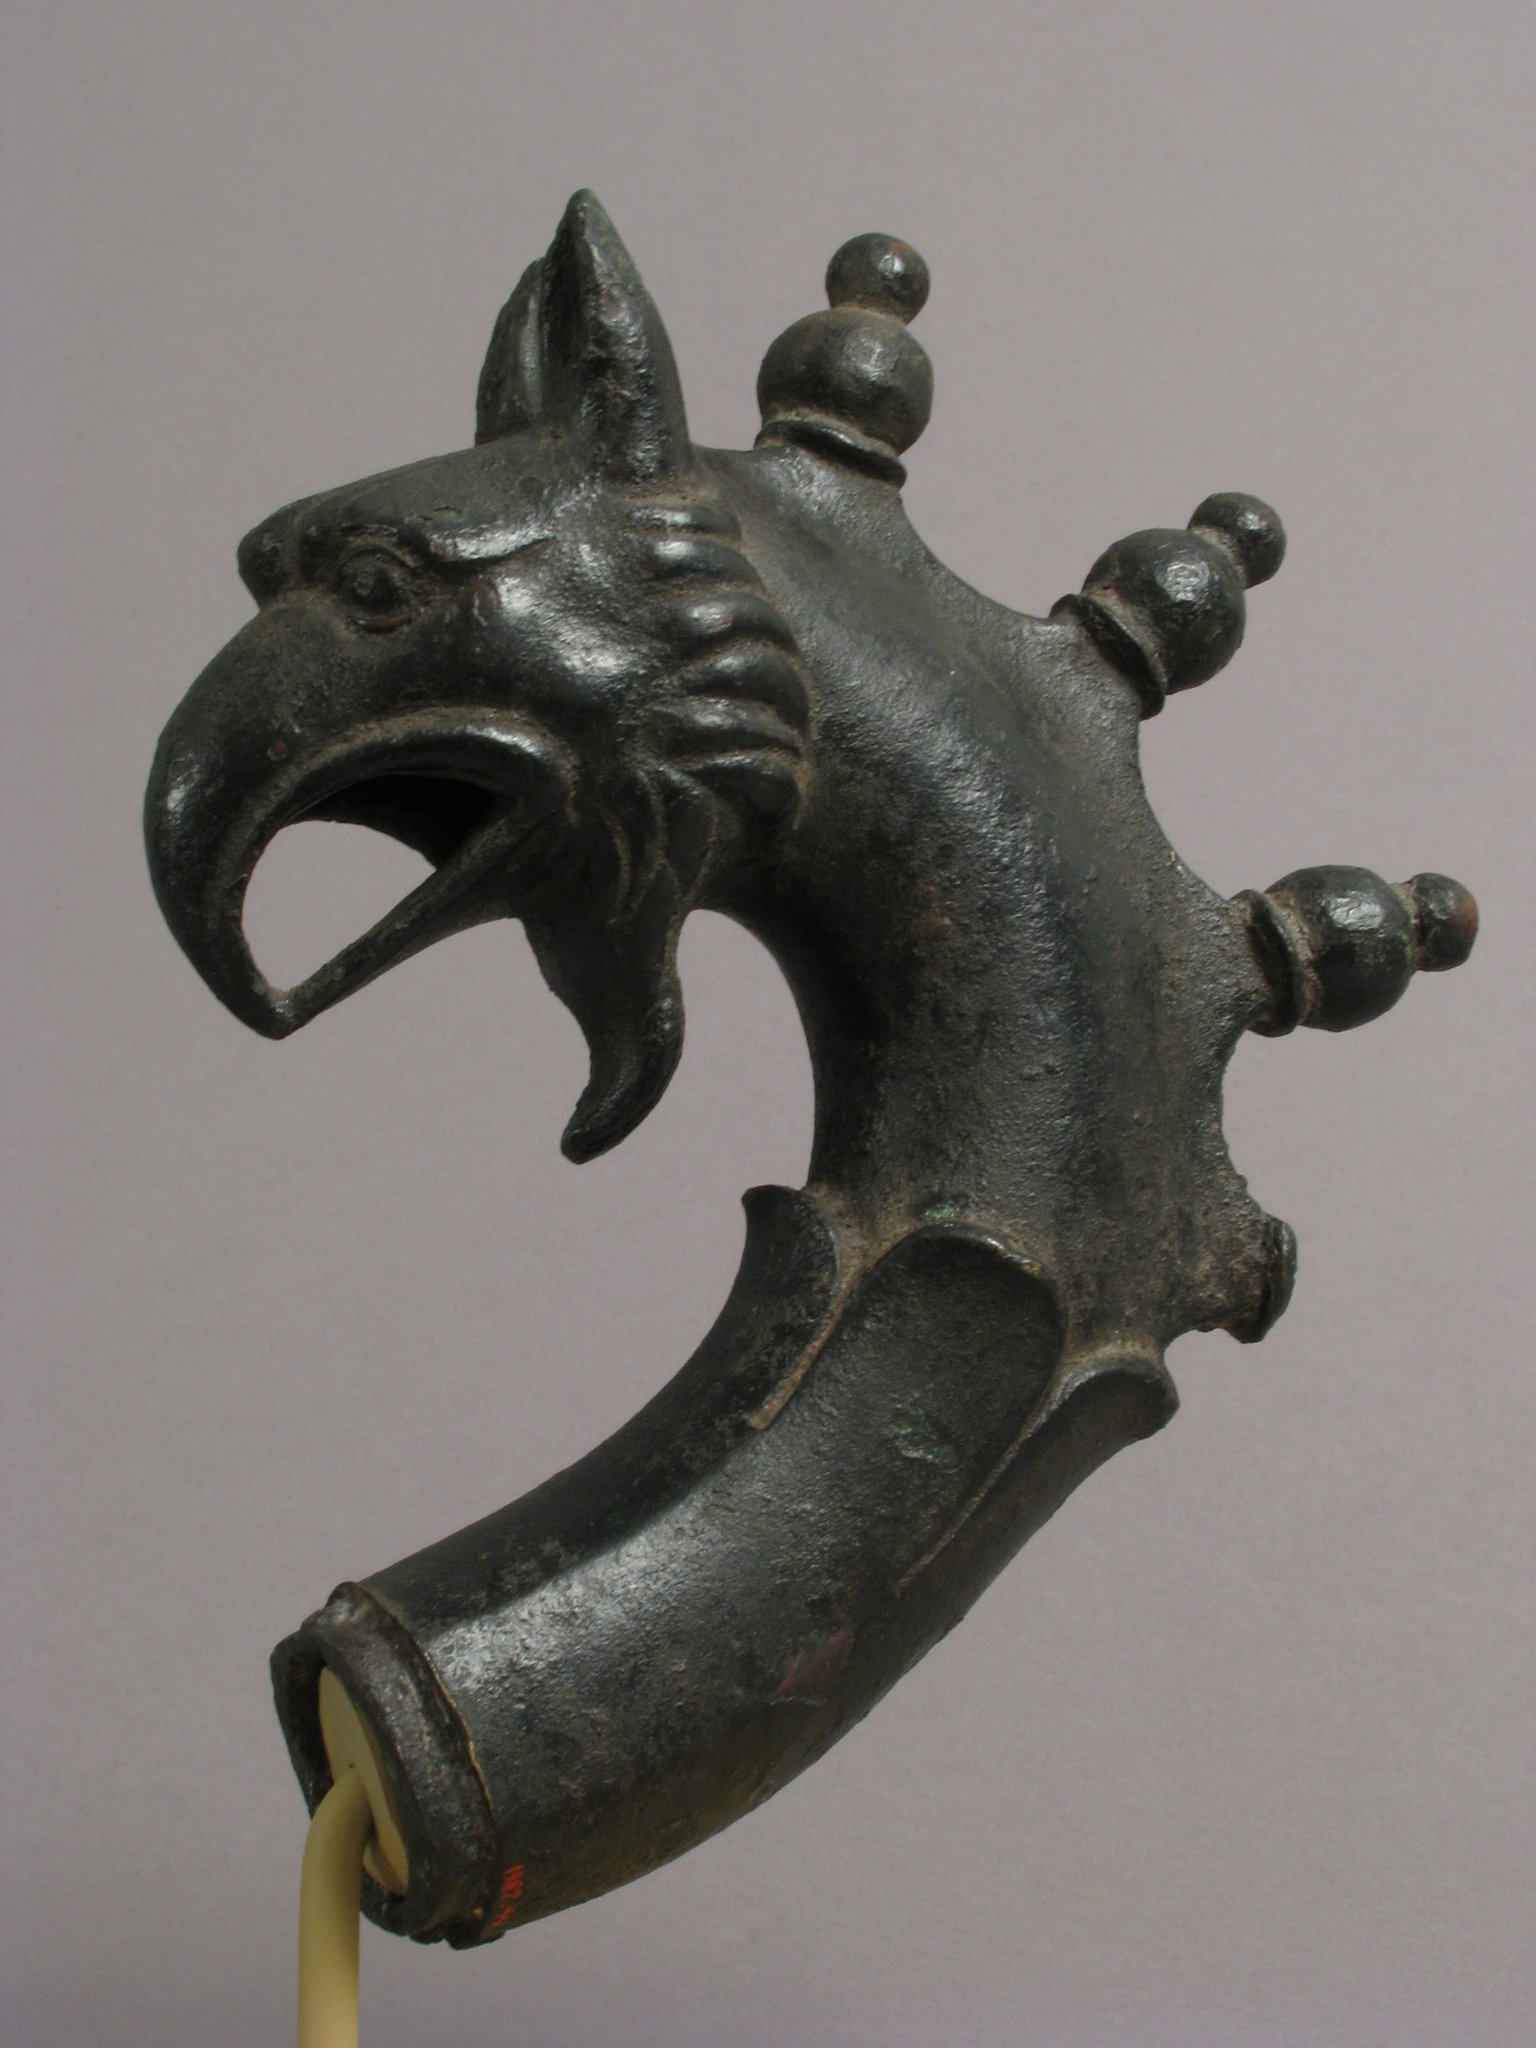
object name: lamp handle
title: Lamp Handle with a Griffin’s Head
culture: byzantine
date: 501-700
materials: copper alloy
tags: griffins